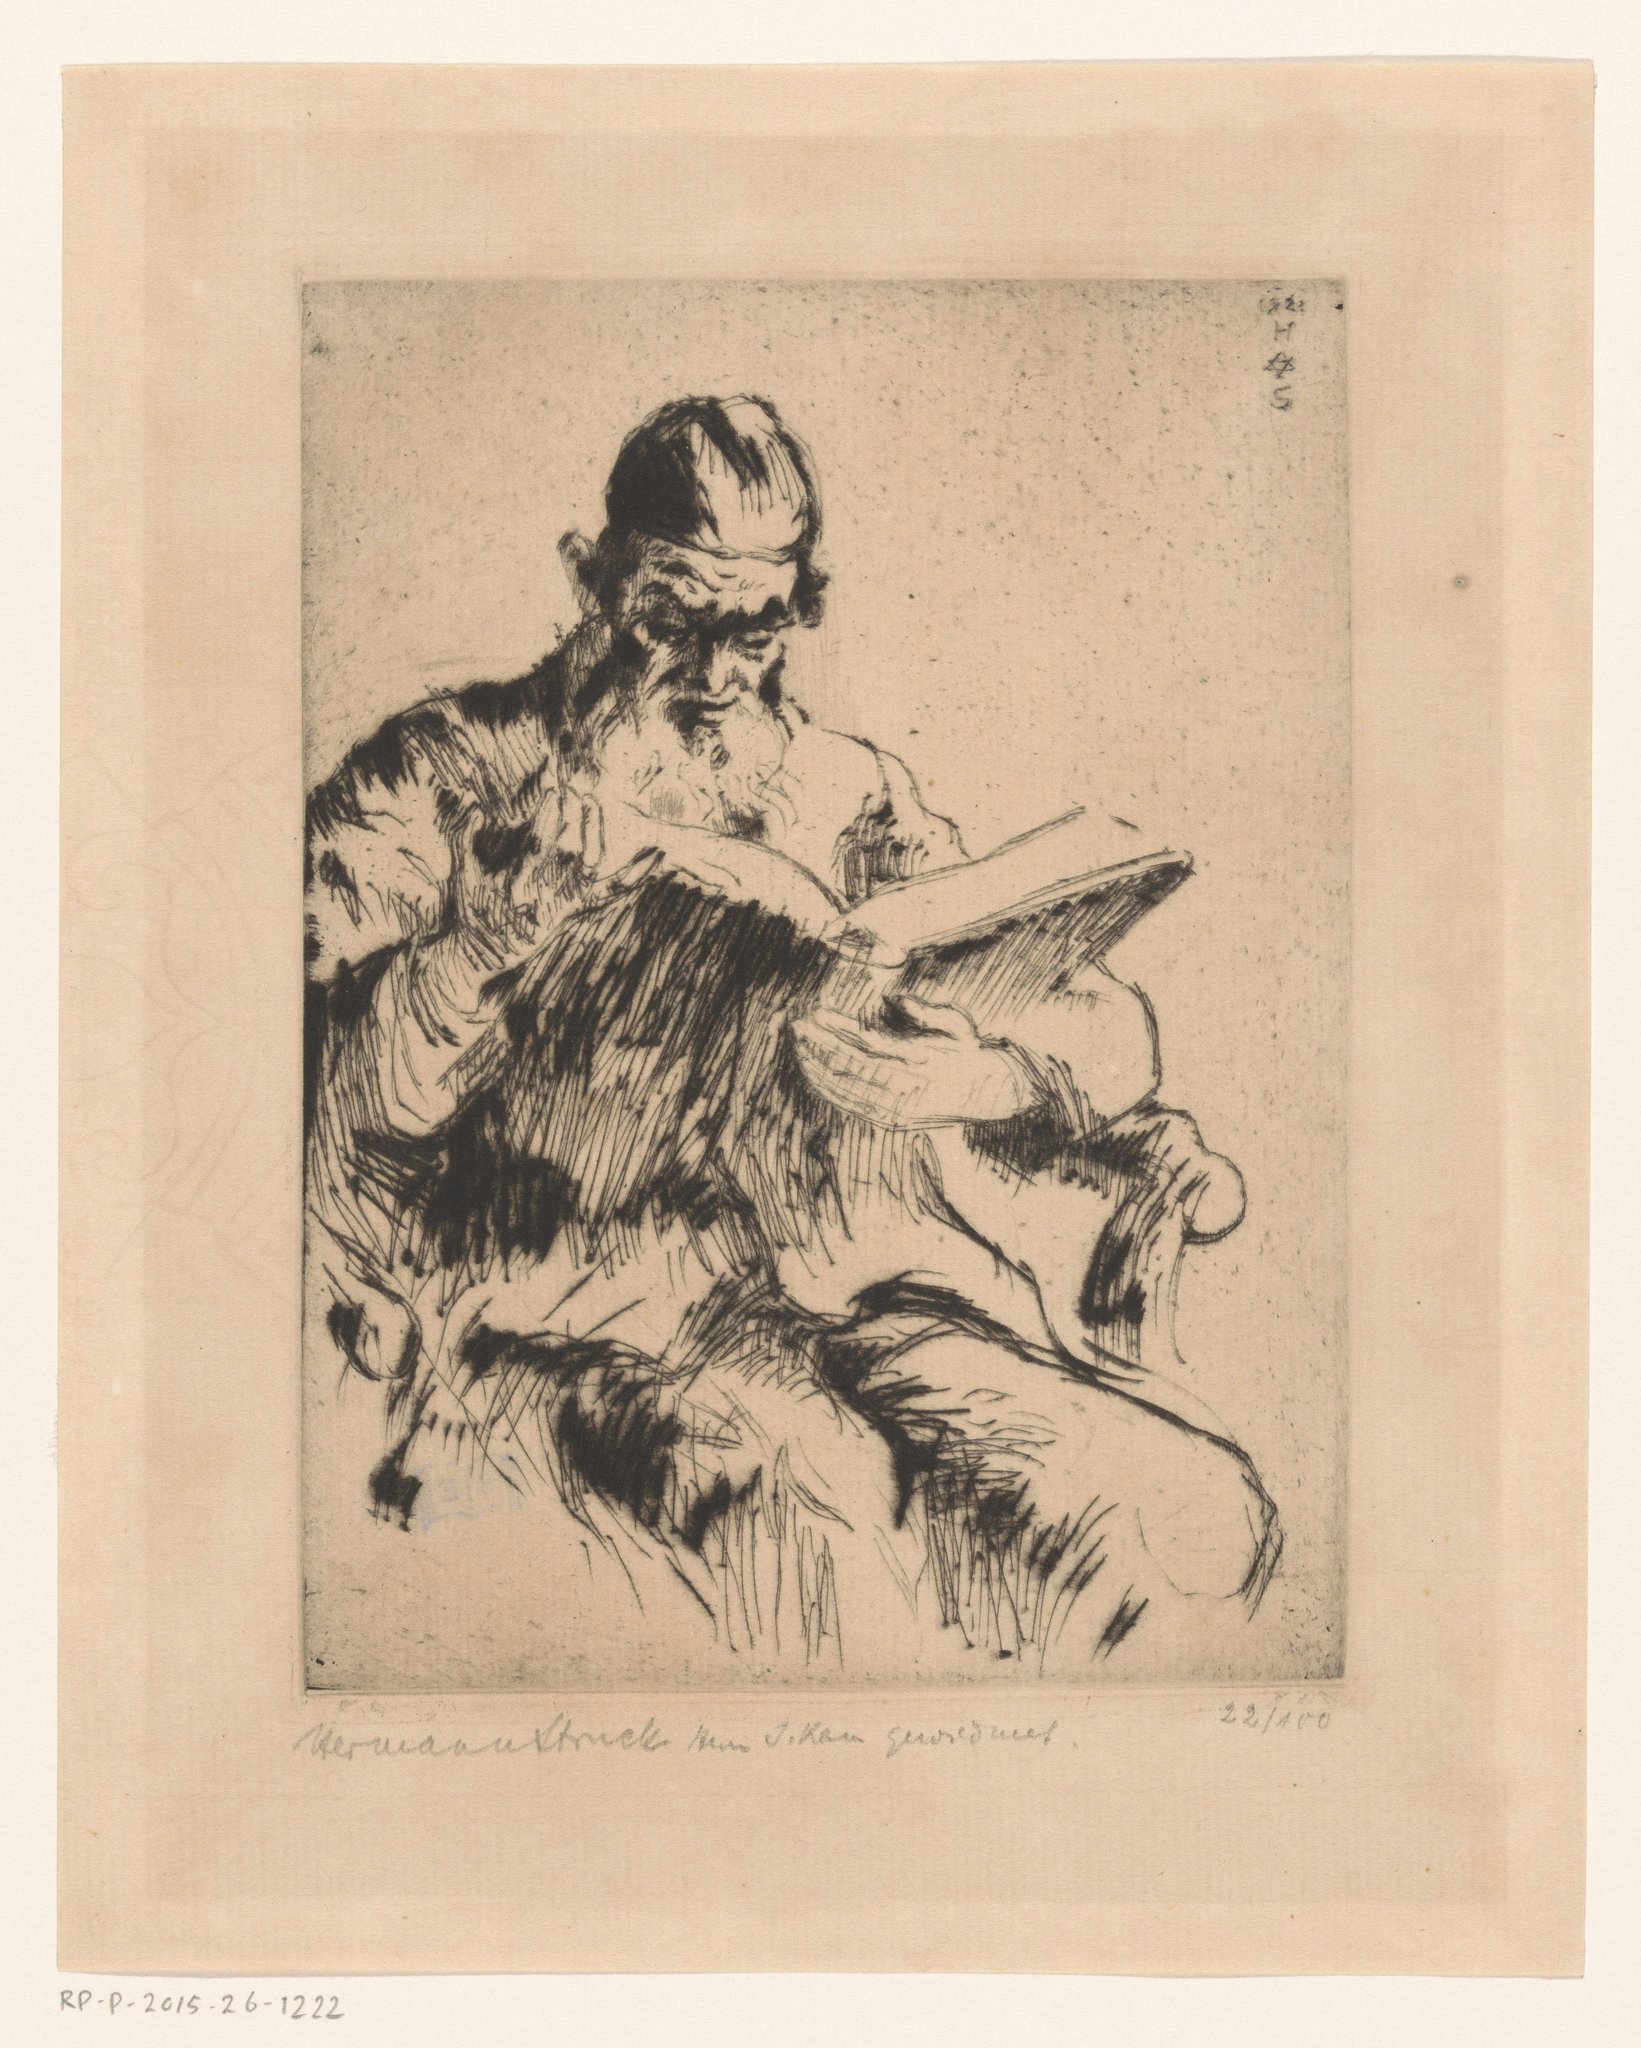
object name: print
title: Lezende joodse man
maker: hermann struck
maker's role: print maker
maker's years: 1876-1944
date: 1921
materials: paper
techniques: drypoint, intaglio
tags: book, newspaper, news-sheet, the jews, jewish life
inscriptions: collector's mark: Lugt 2228, collector's mark: Lugt 4779, dedication: ‘Hermann Struck Herr J. Kan gewidmet’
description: Portret van een lezende joodse man met een boek in zijn handen, zittend op een stoel.